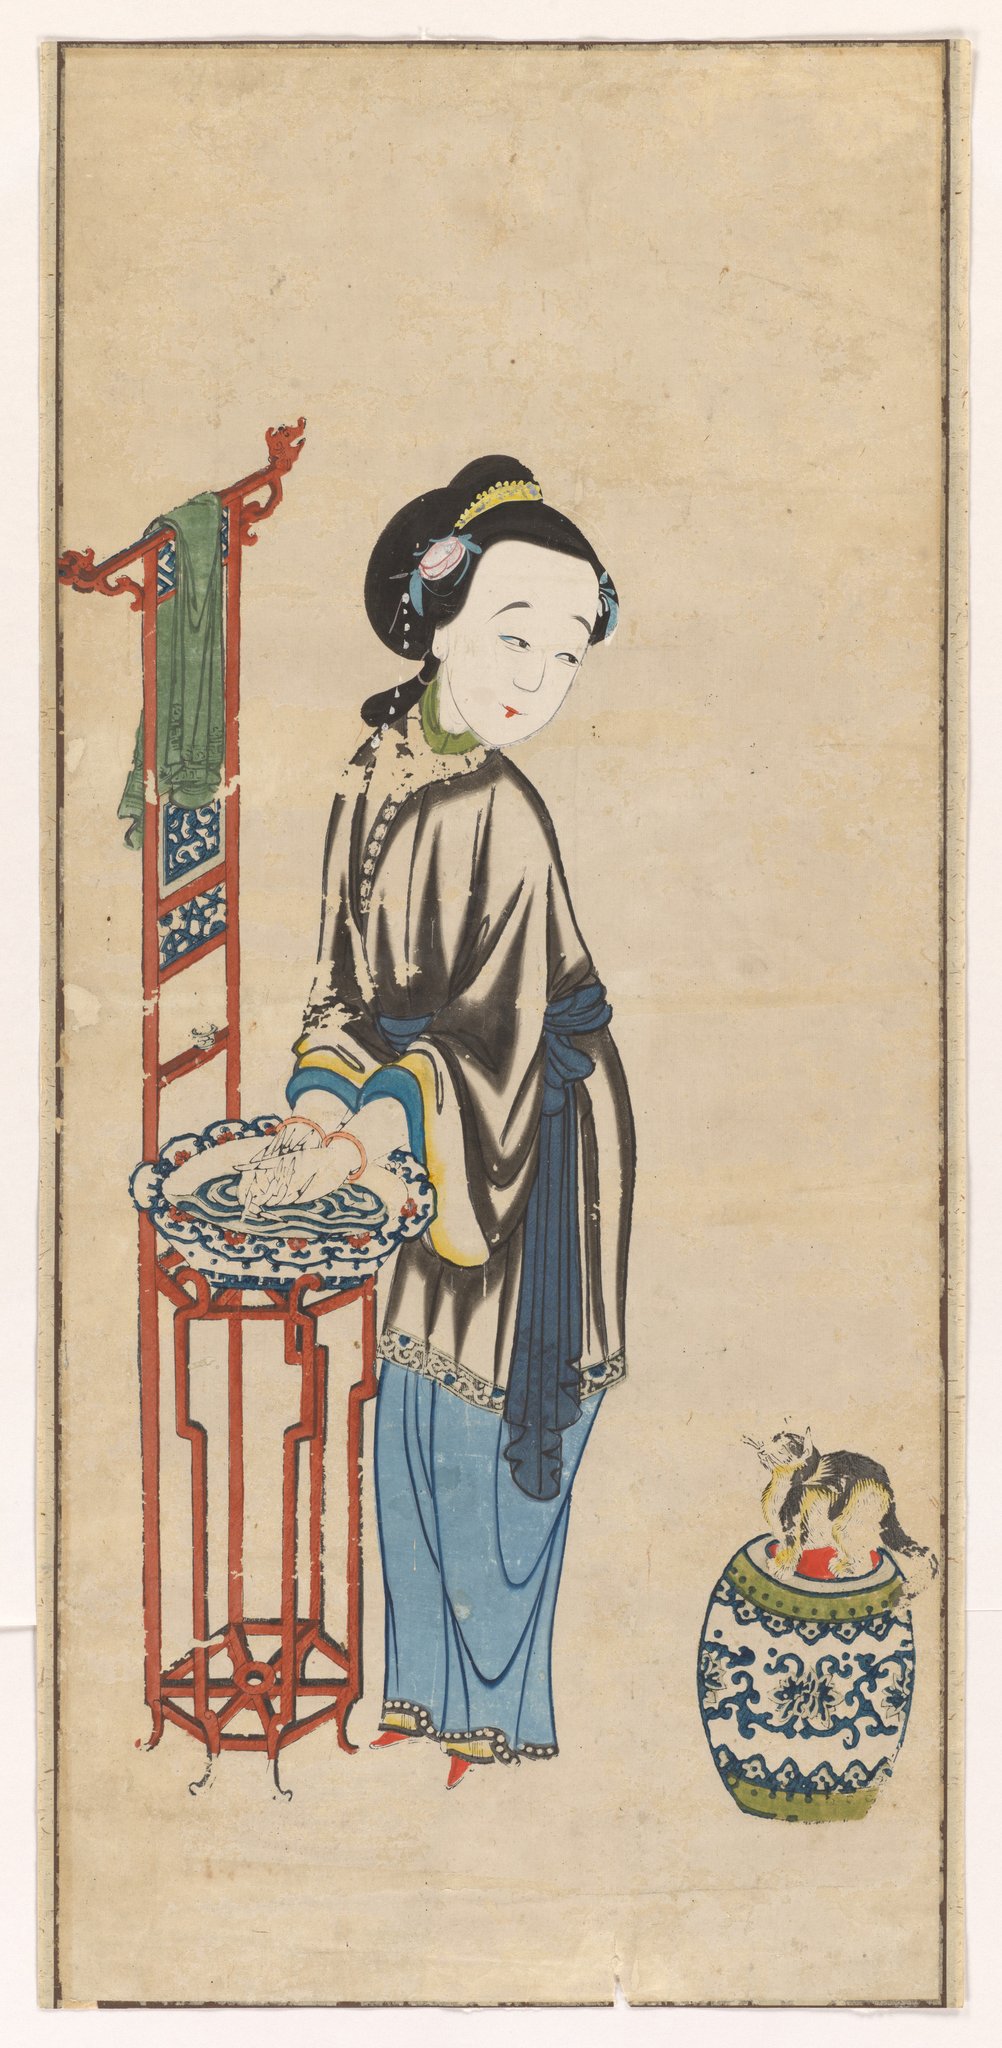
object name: print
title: Beauty and a Cat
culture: chinese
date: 1736-1795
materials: ink, paper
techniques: hand coloring, woodblock print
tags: women,cats